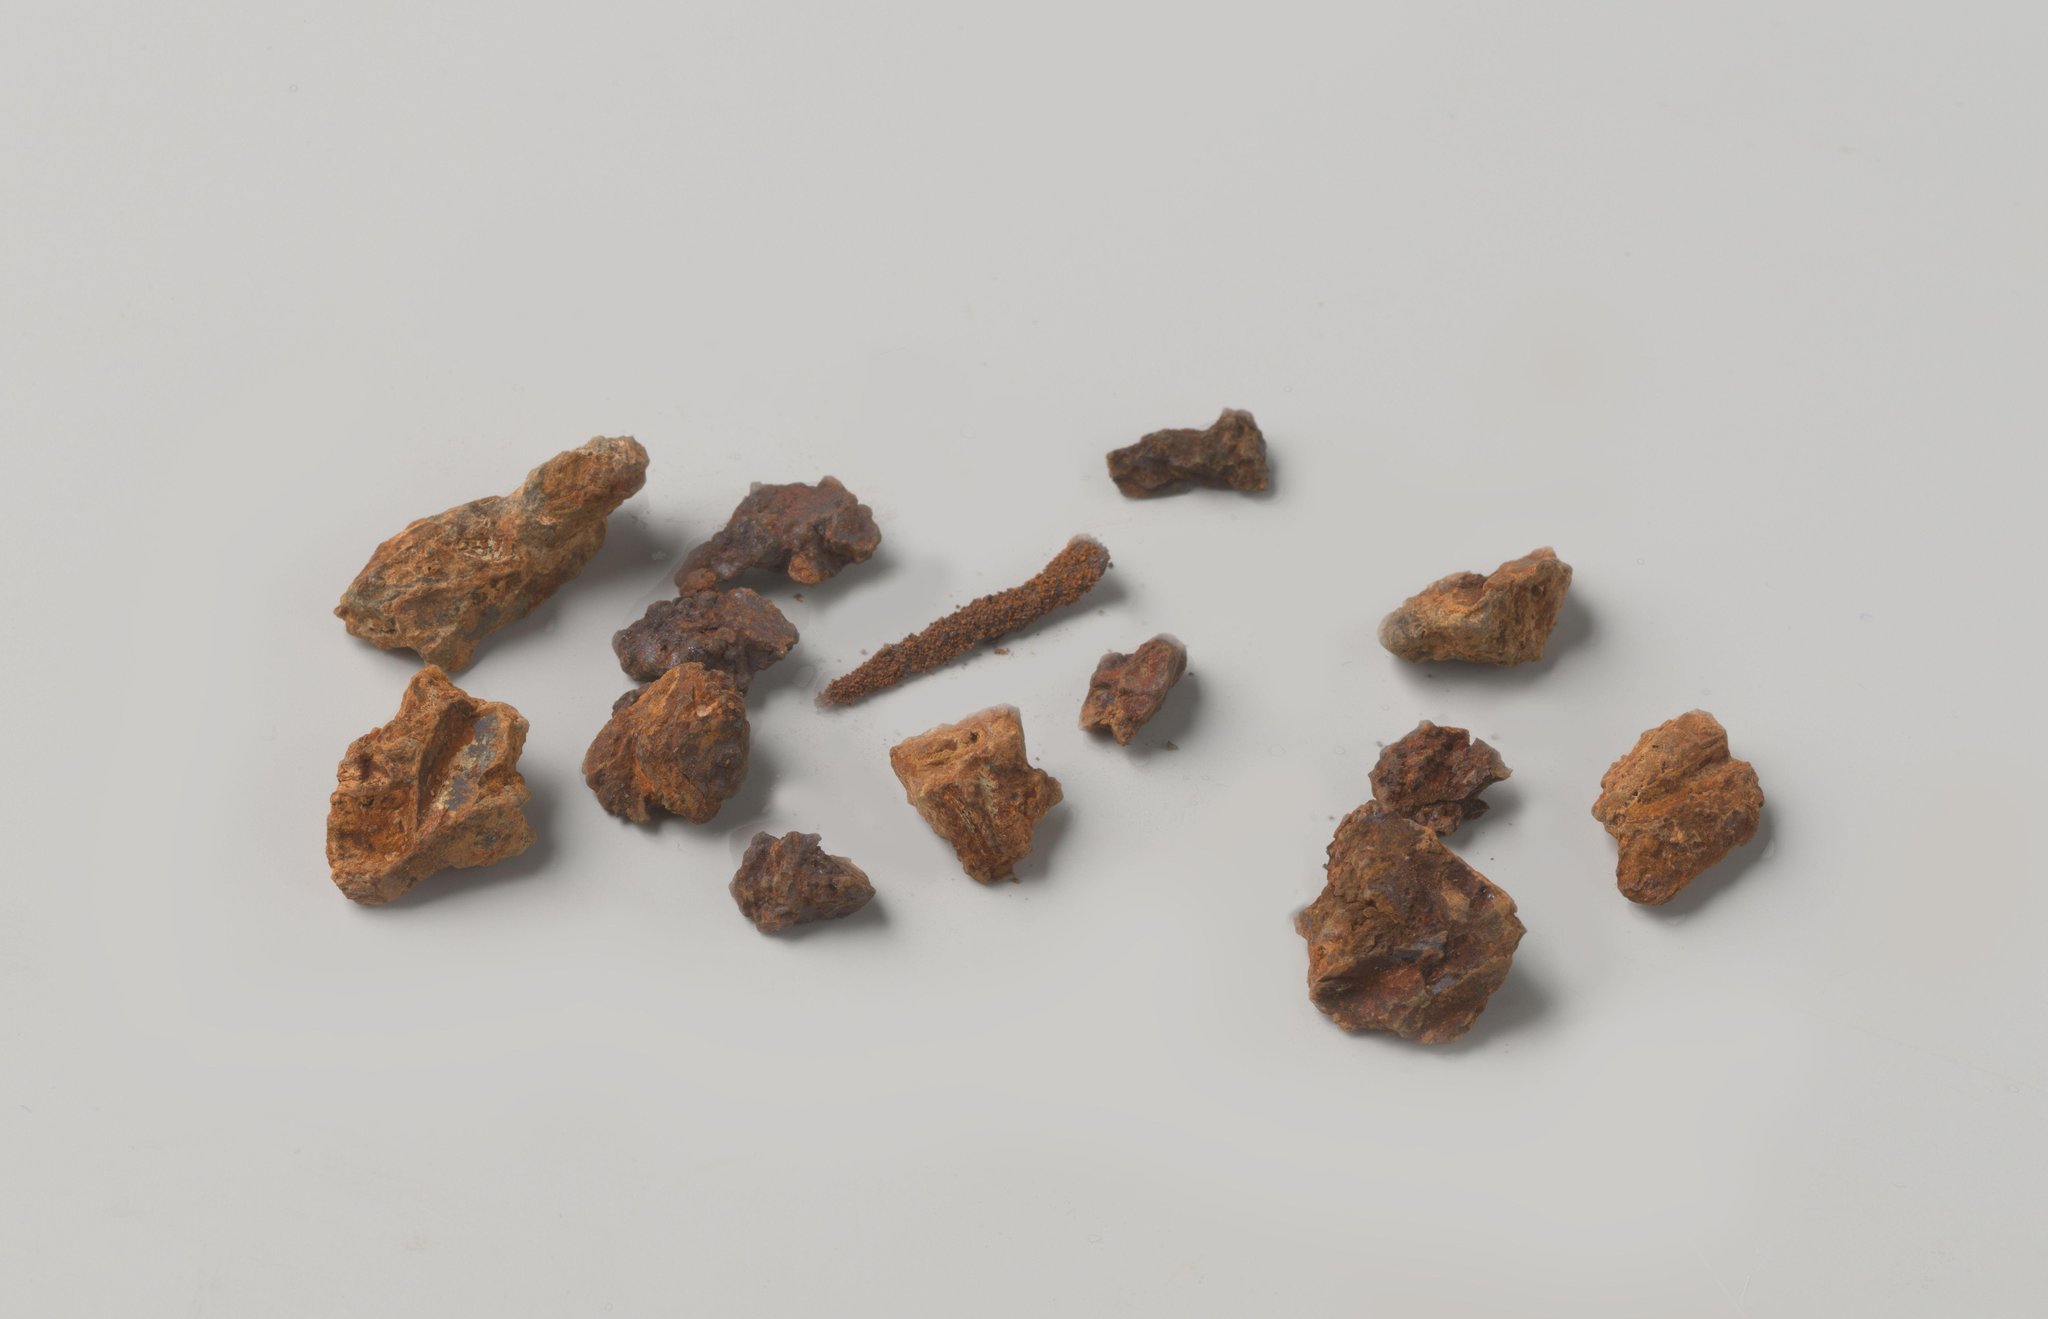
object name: concretionary stone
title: Gecorrodeerde spijkers met concretie uit het wrak van de Oostindiëvaarder Hollandia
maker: Anonymous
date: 1700-1743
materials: stone, iron